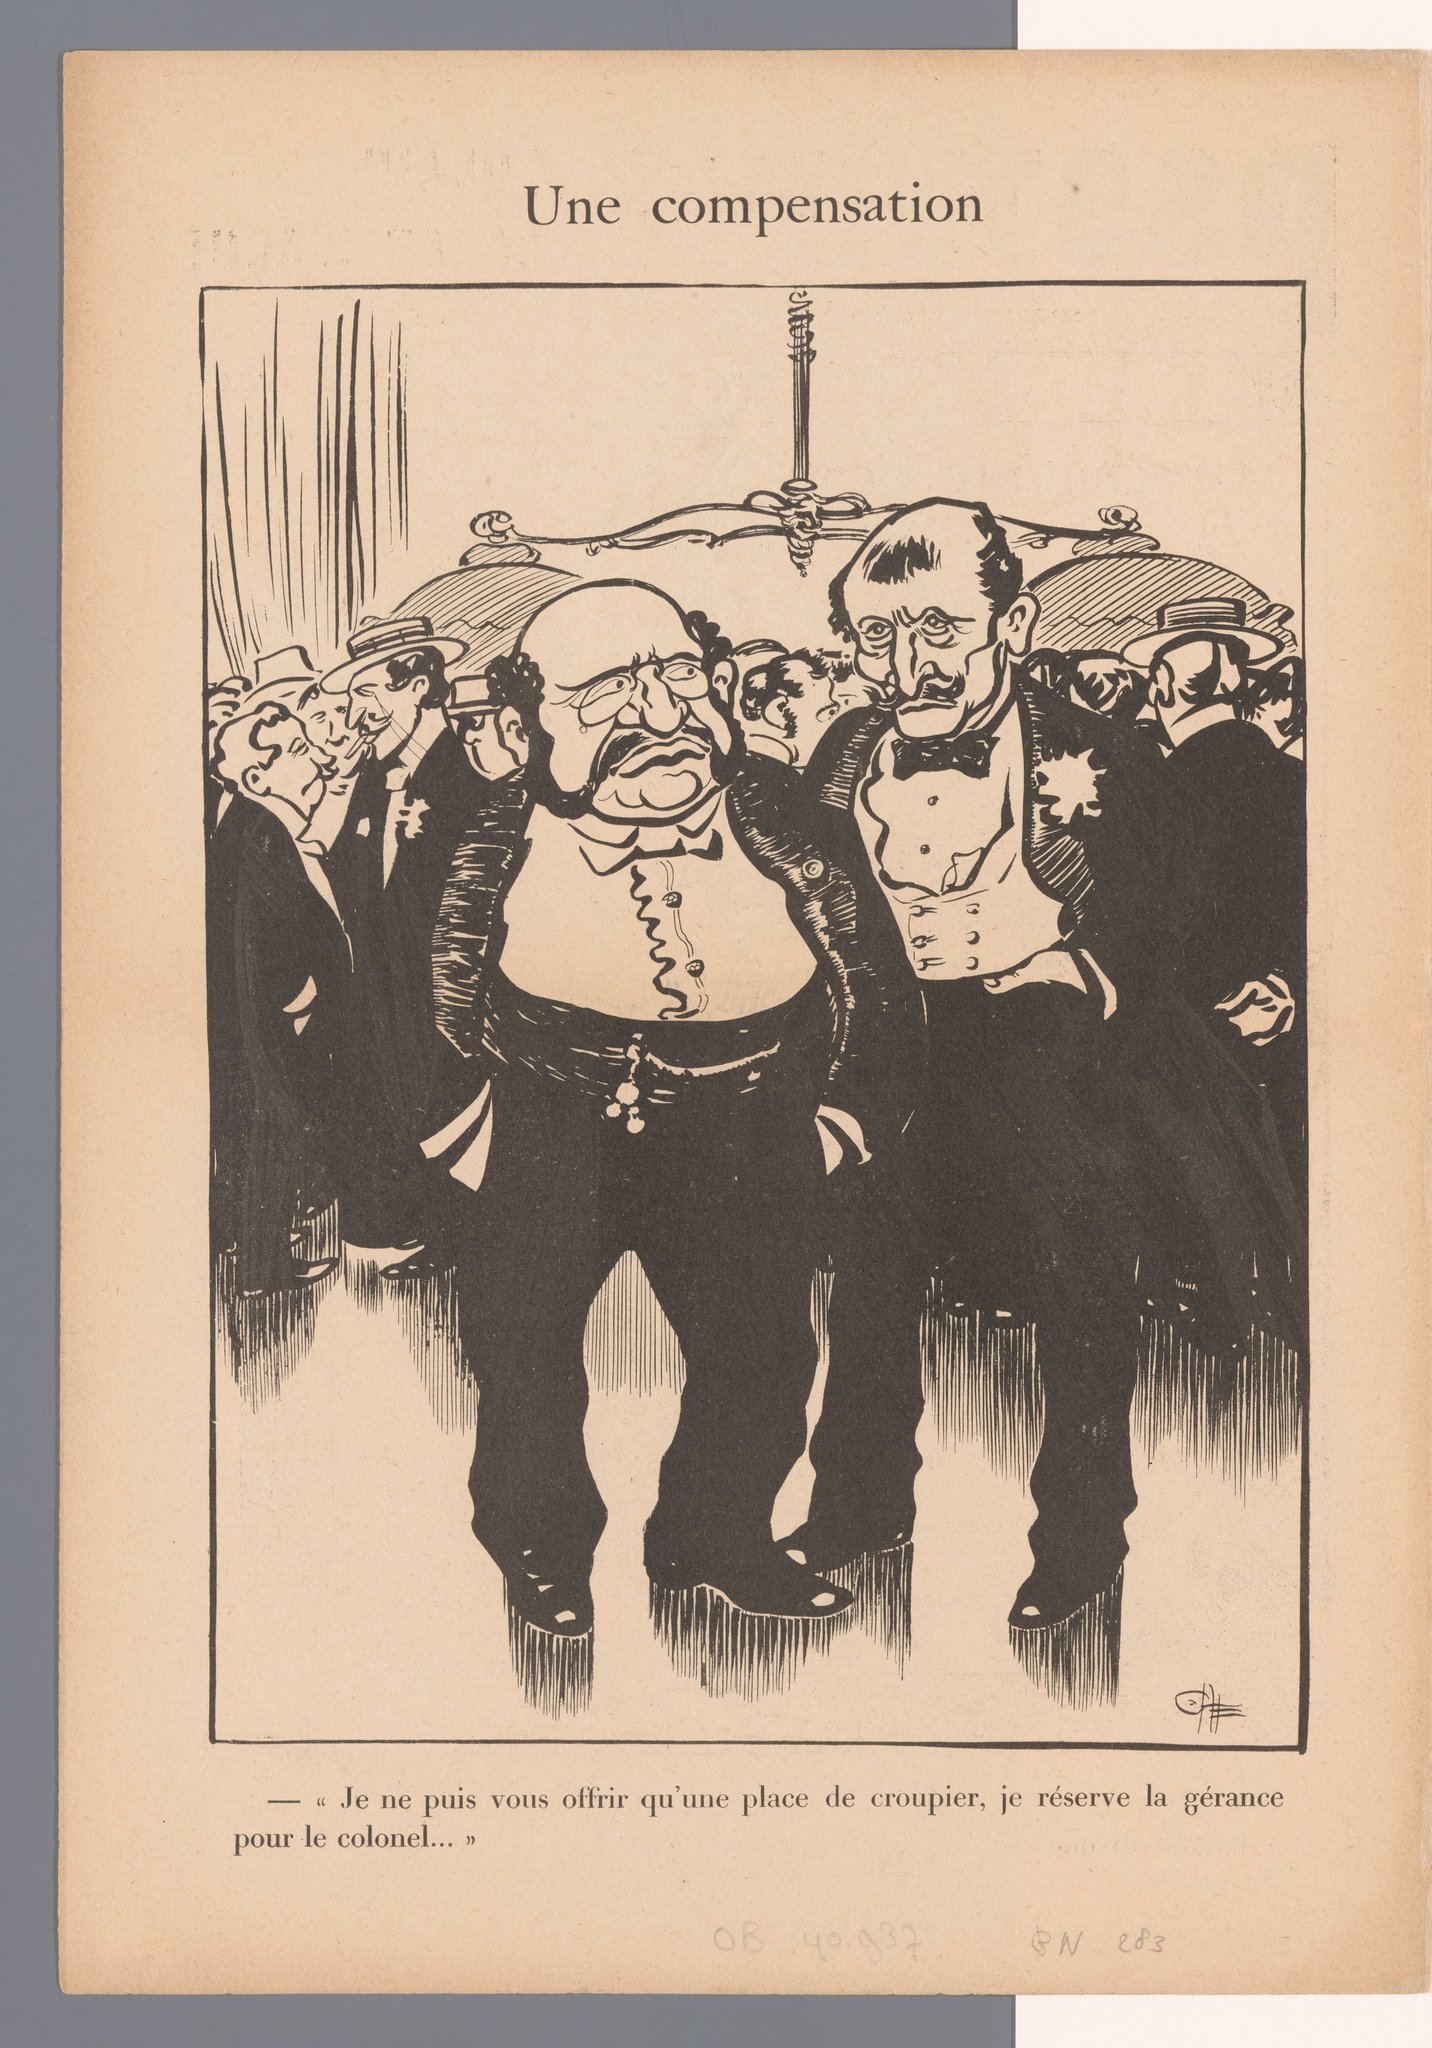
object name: magazine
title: Karikatuur van twee dreyfusards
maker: caran dache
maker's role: draughtsman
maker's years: 1859-1909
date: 1898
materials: paper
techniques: lithograph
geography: paris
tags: caricatures (human types), political caricatures and satires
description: Prent gebruikt voor: Psst...!, nr. 29, 20 augustus 1898. Psst..! was een politieke weekkrant met antisemitische en anti-Dreyfus cartoons.